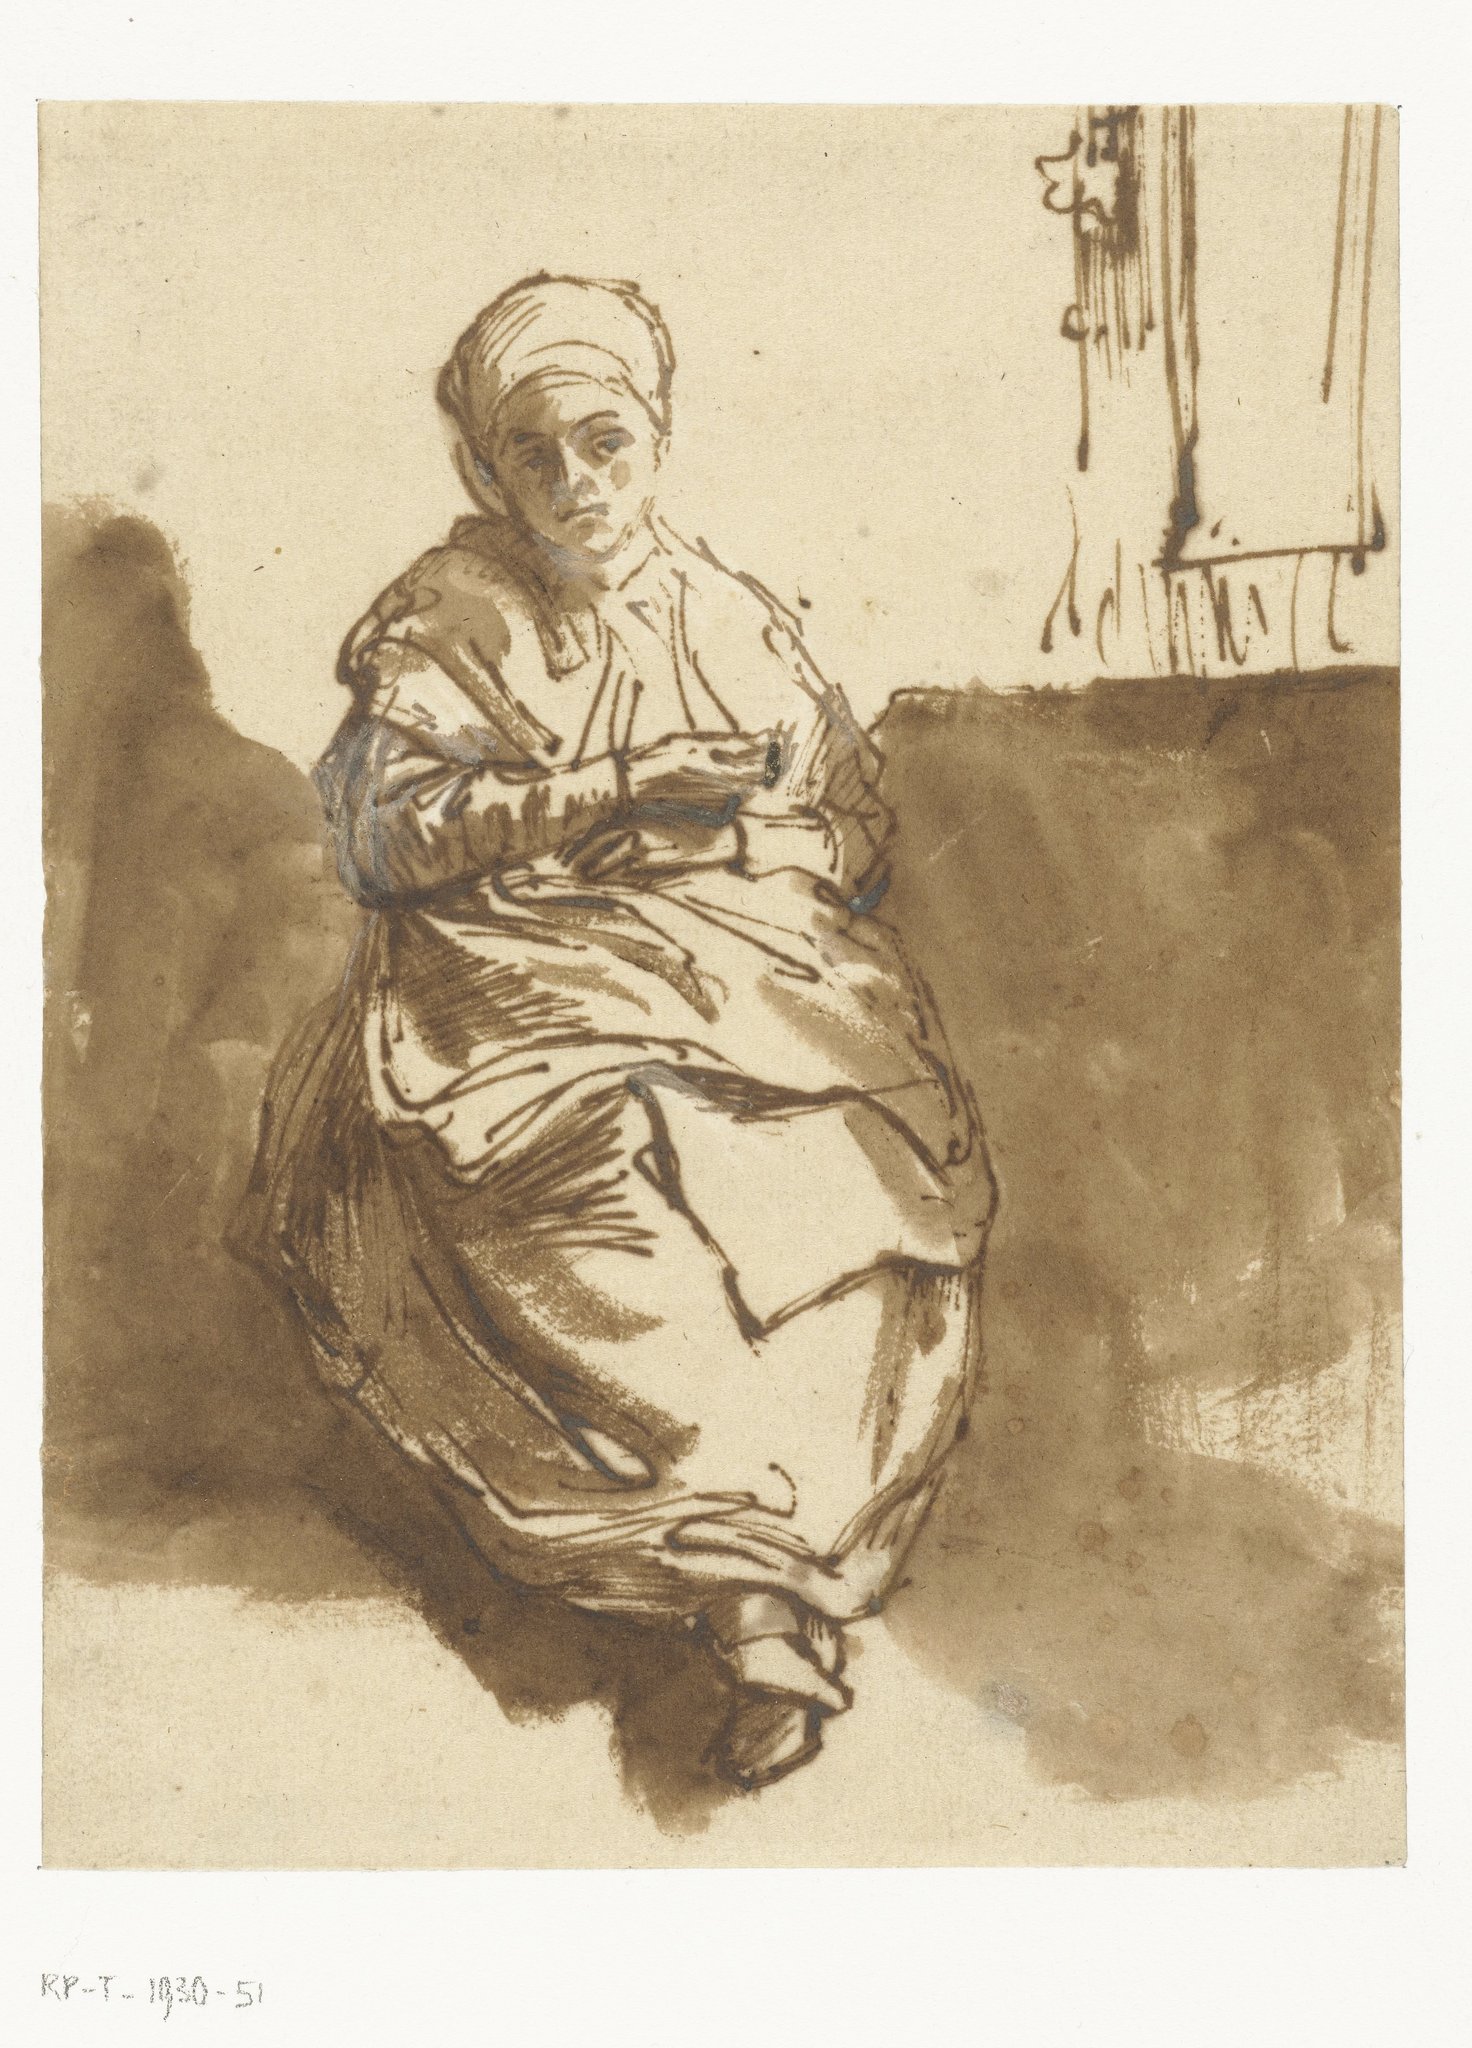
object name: drawing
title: Young Woman Seated by a Window (Saskia?)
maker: rembrandt van rijn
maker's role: draughtsman, painter, print maker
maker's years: 1606-1669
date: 1638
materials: paint, paper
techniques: brush, pen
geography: amsterdam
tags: historical persons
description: This drawing is often regarded as a ‘portrait’ of Saskia. If so, she consciously plays a role here. Wearing a simple cloth around her head and an apron, it seems as if she has come straight out of the kitchen. Saskia, however, was a mayor’s daughter and married to an artist full of social ambitions. She would thus never have walked around the house dressed like a kitchen maid.